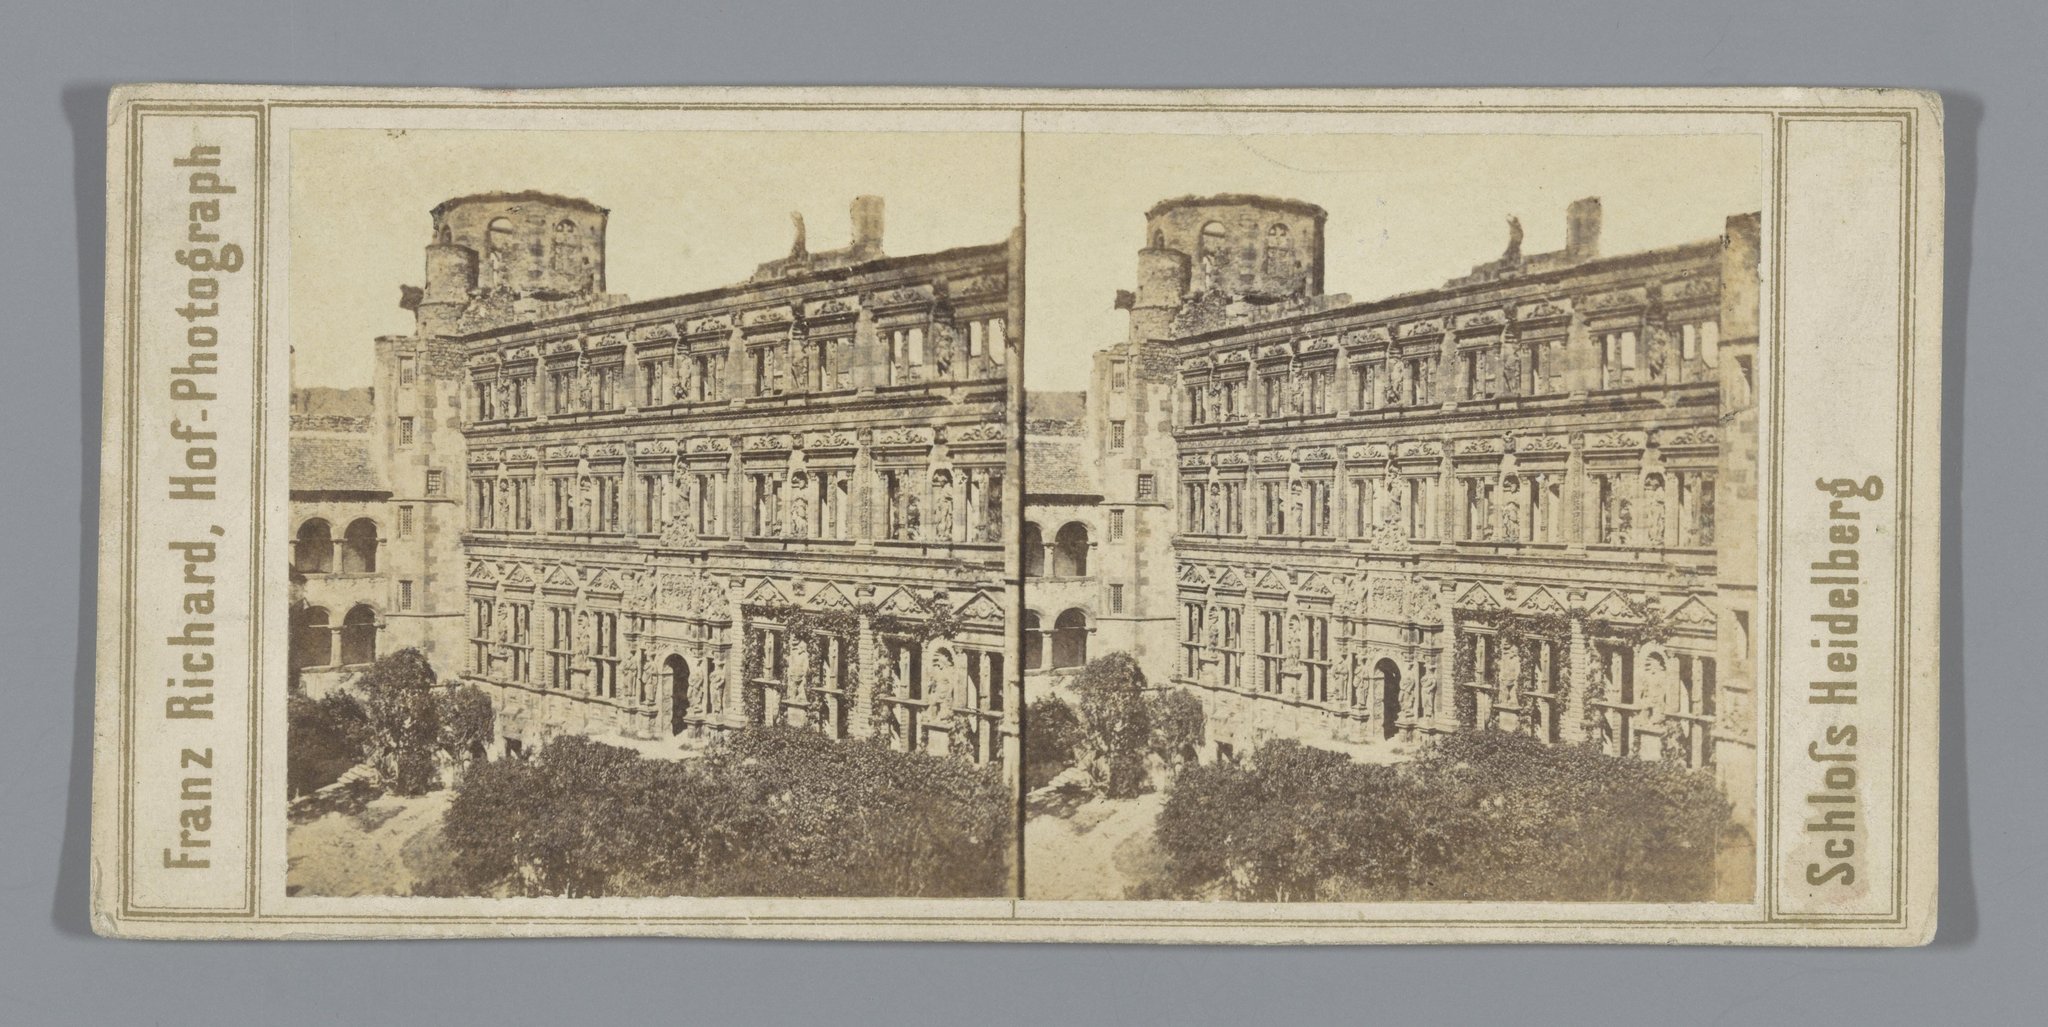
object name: stereograph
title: Schloss Heidelberg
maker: franz richard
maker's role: fotograaf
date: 1860-1880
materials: cardboard, photographic support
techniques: albumen print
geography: heidelberg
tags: castle, façade (of house or building)